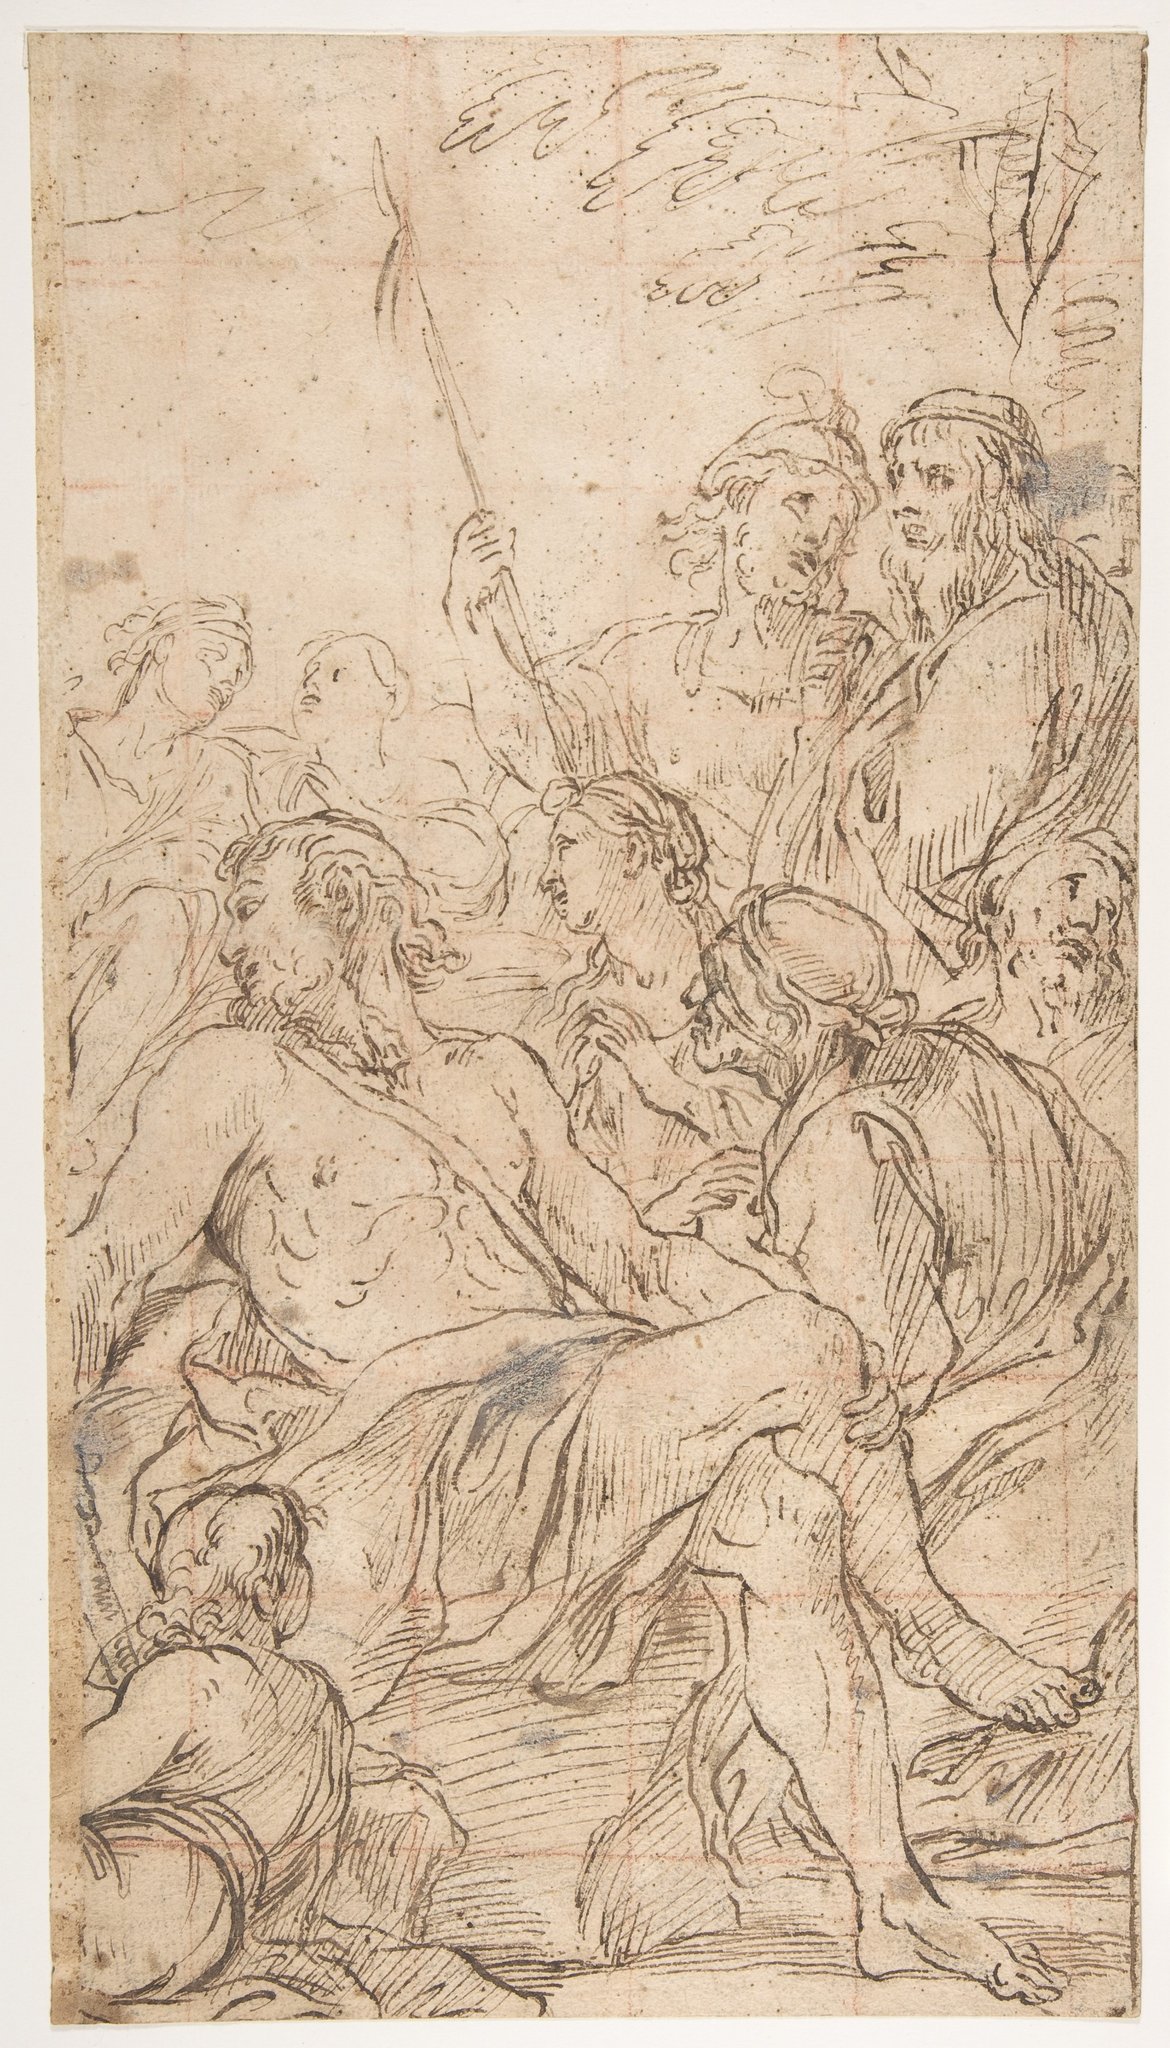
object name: drawing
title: Fragment of a Composition with a Reclining Semi-Nude Man Surrounded by Soldiers and Other Onlookers in a Landscape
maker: luca giordano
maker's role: artist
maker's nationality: italian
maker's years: 1634-1705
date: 1634-1705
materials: chalk, ink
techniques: pen, drawing, transfer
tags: soldiers,men,landscapes